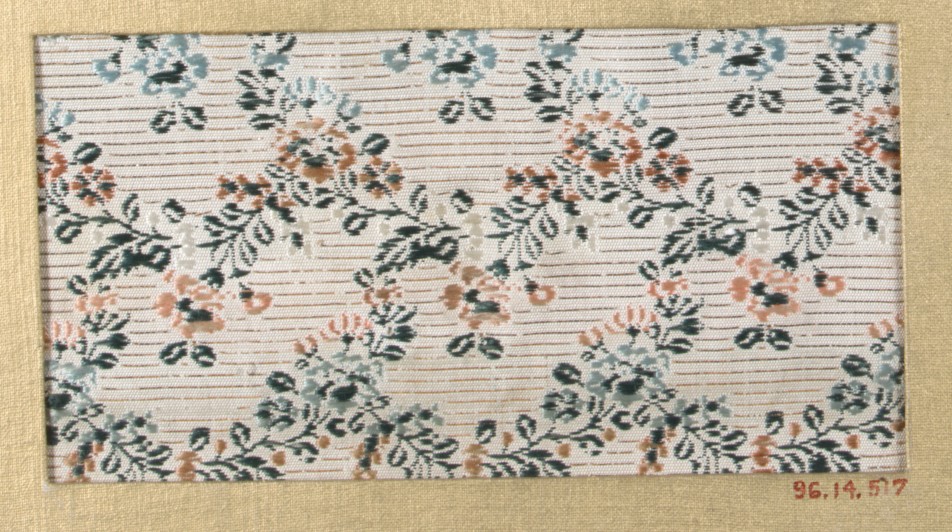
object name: piece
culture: japanese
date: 1701-1900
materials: silk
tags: flowers